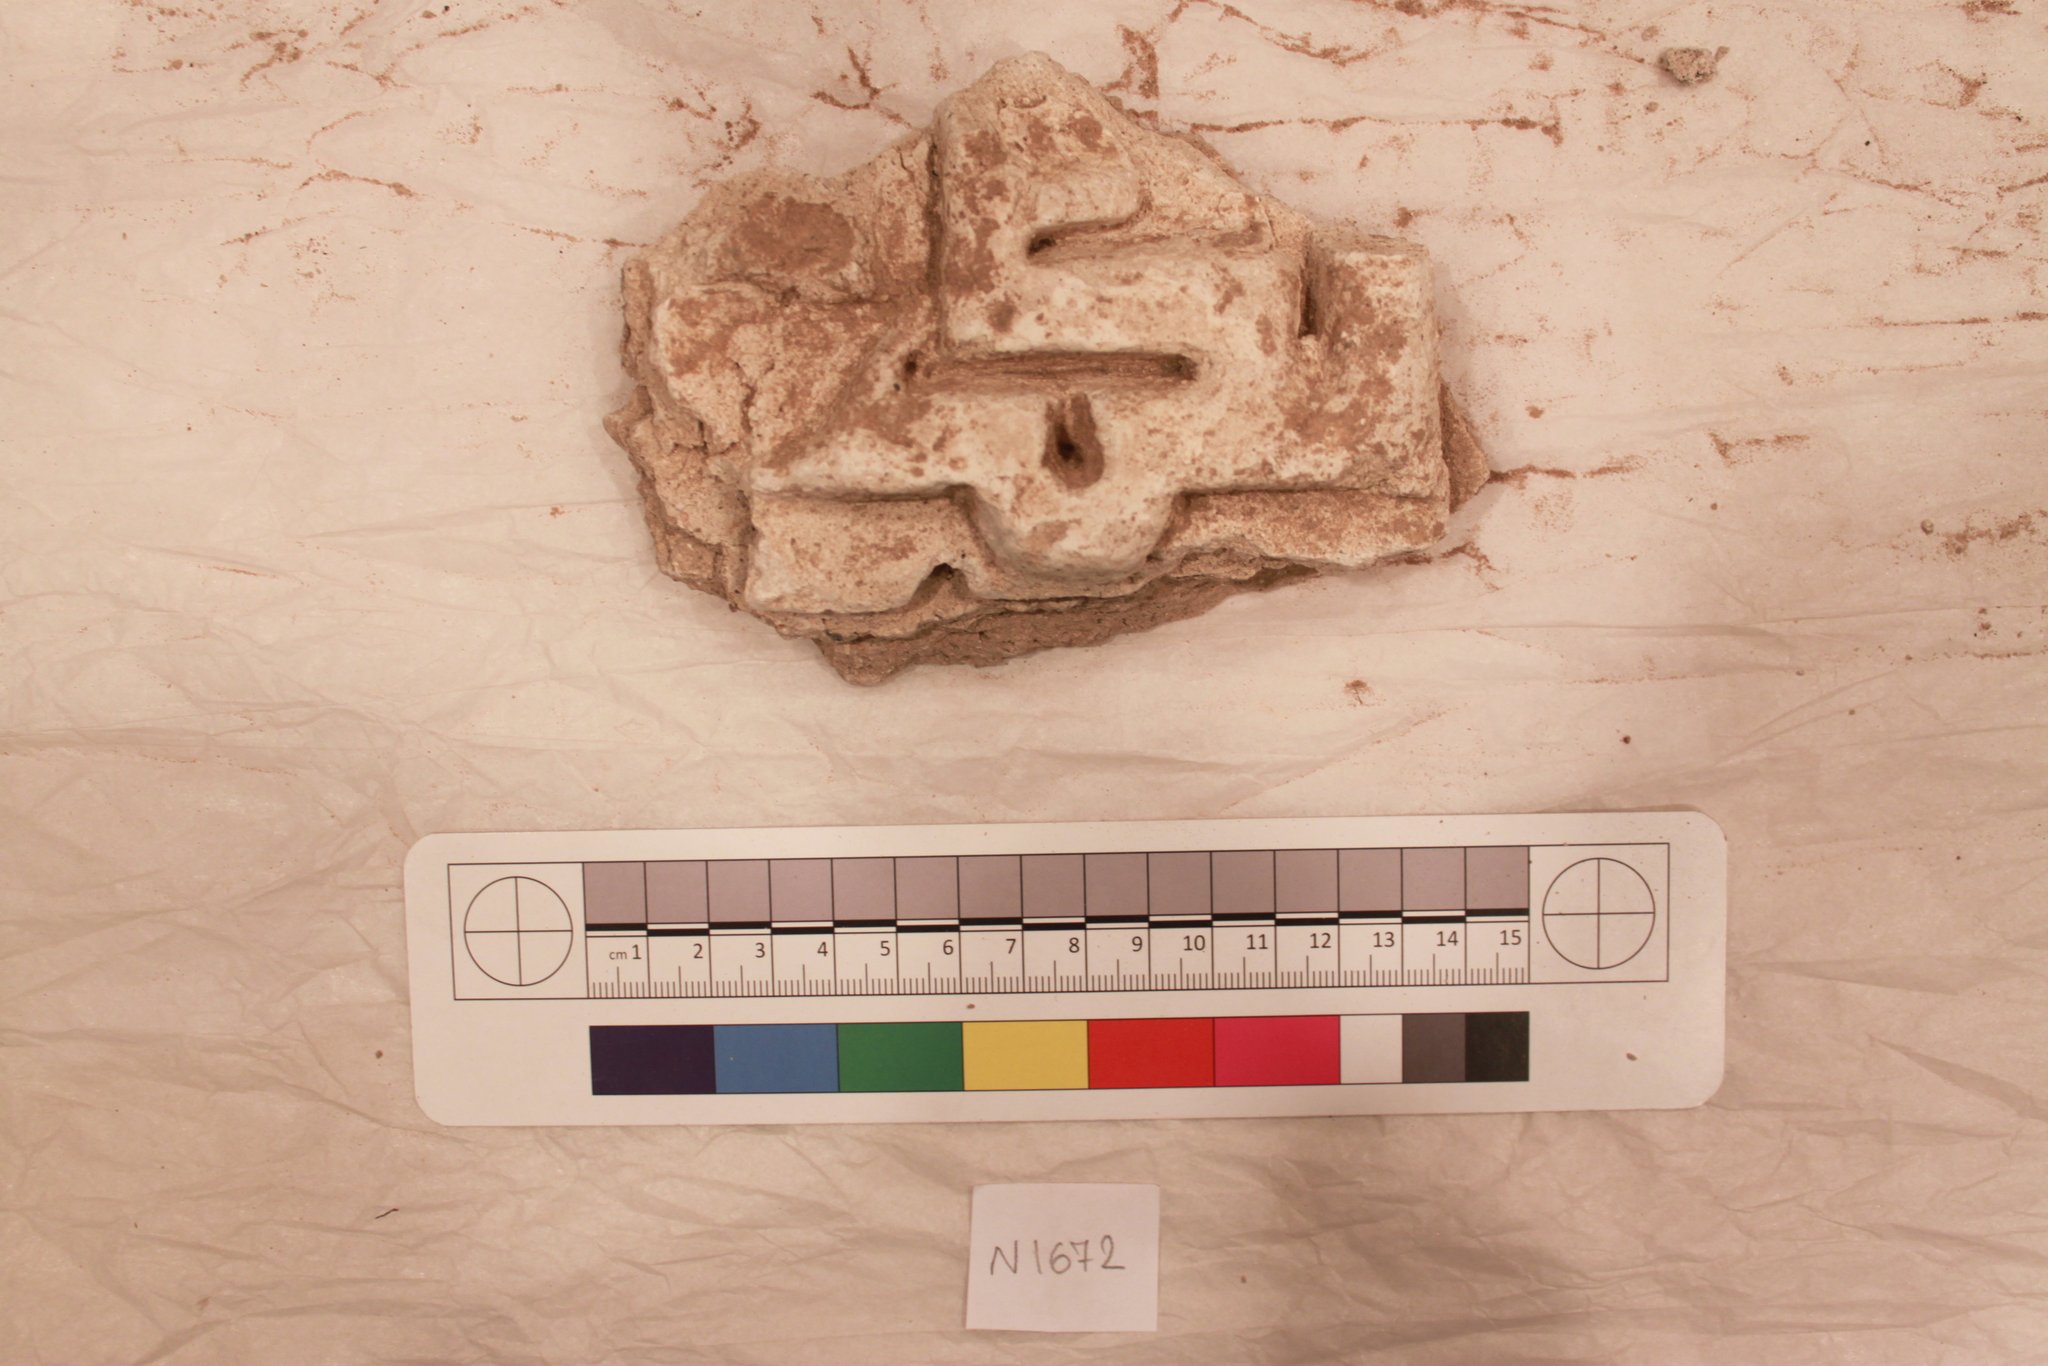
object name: fragment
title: Stucco Fragment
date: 701-1200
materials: plaster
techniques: carving, painting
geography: iran